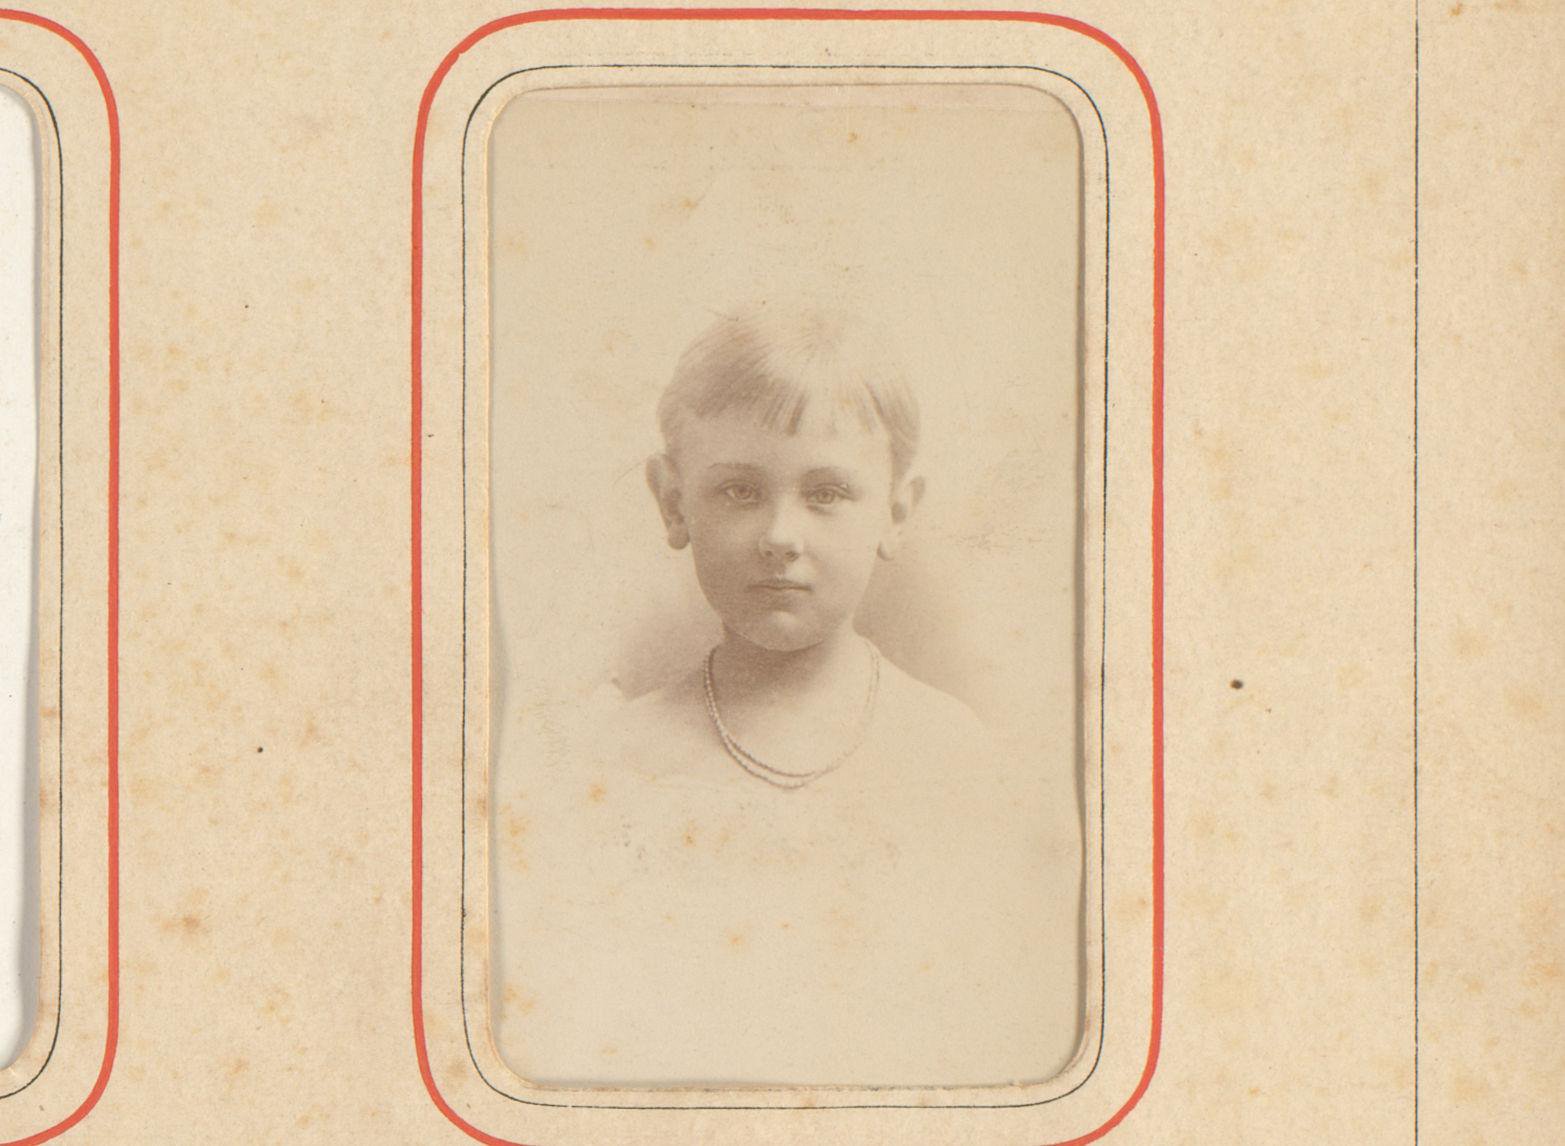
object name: album leaf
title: Portret van Wilhelmina der Nederlanden als kind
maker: Anonymous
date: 1885-1890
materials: cardboard, paper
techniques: albumen print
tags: the hague, print maker, wilhelmina of the netherlands, historical persons - bb - woman